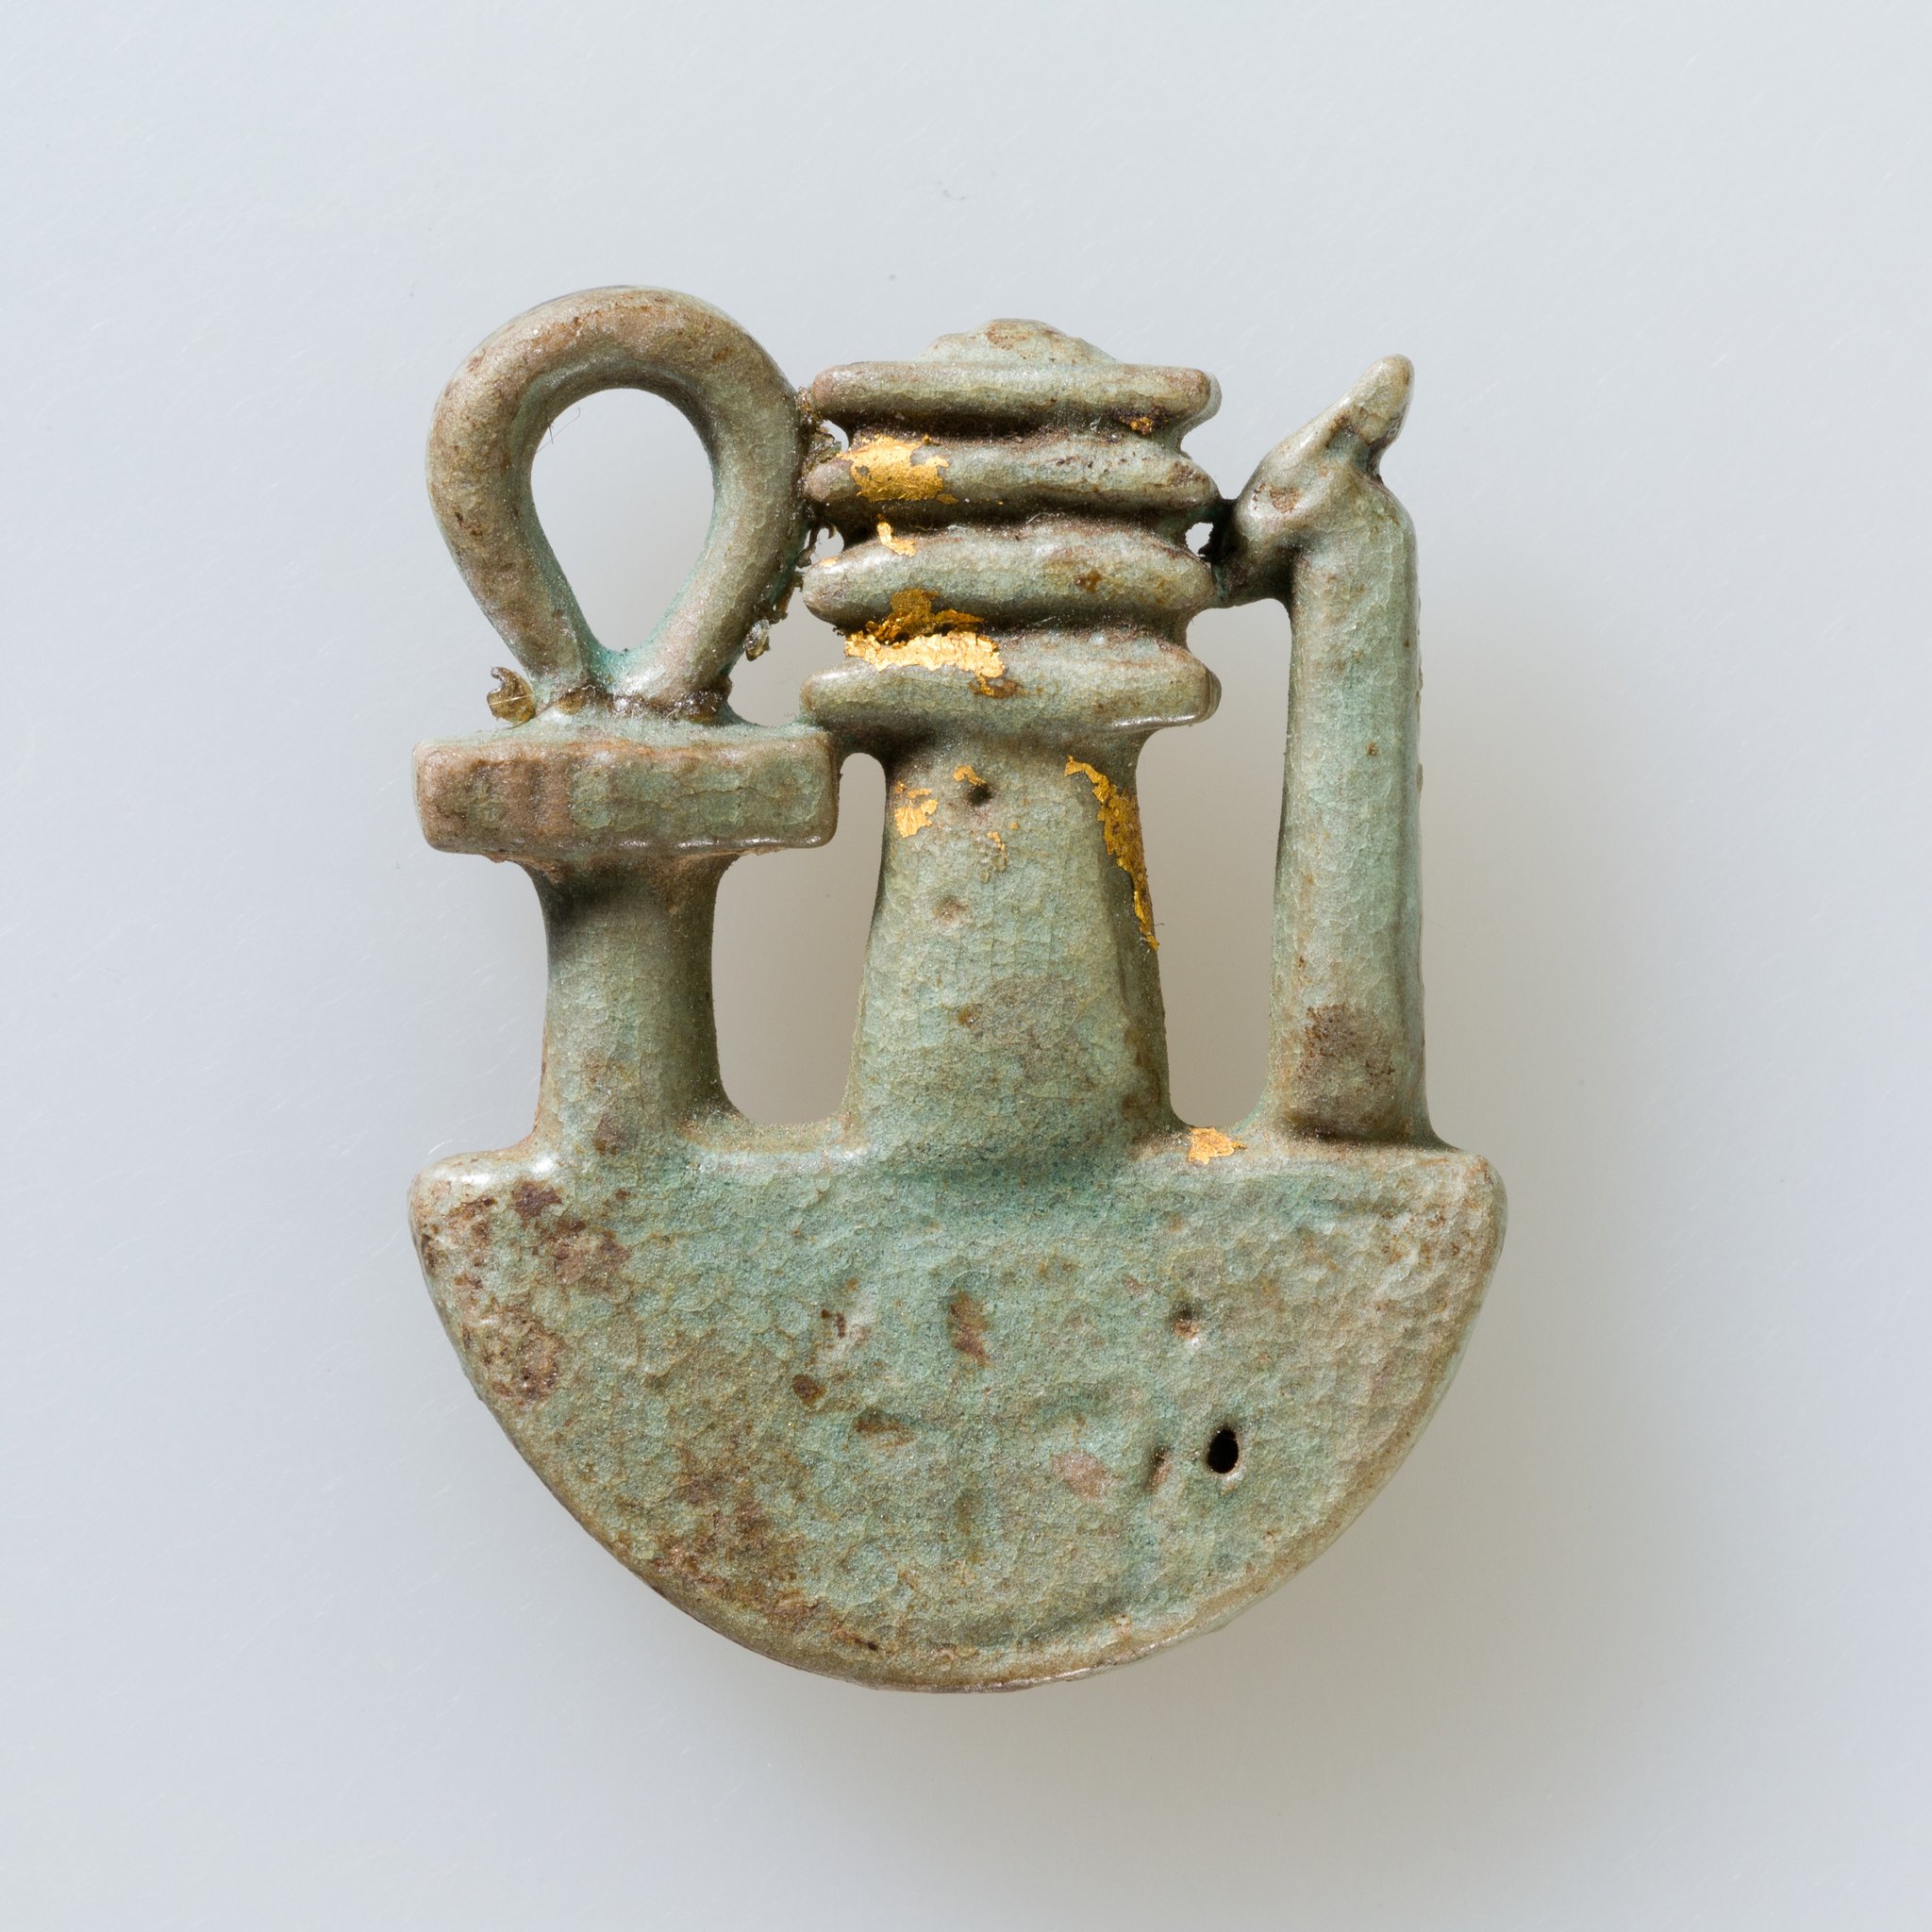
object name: amulet, ankh, wa scepter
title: Ankh, djed, was on neb basket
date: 664-630 BCE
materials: faience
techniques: gilding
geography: egypt